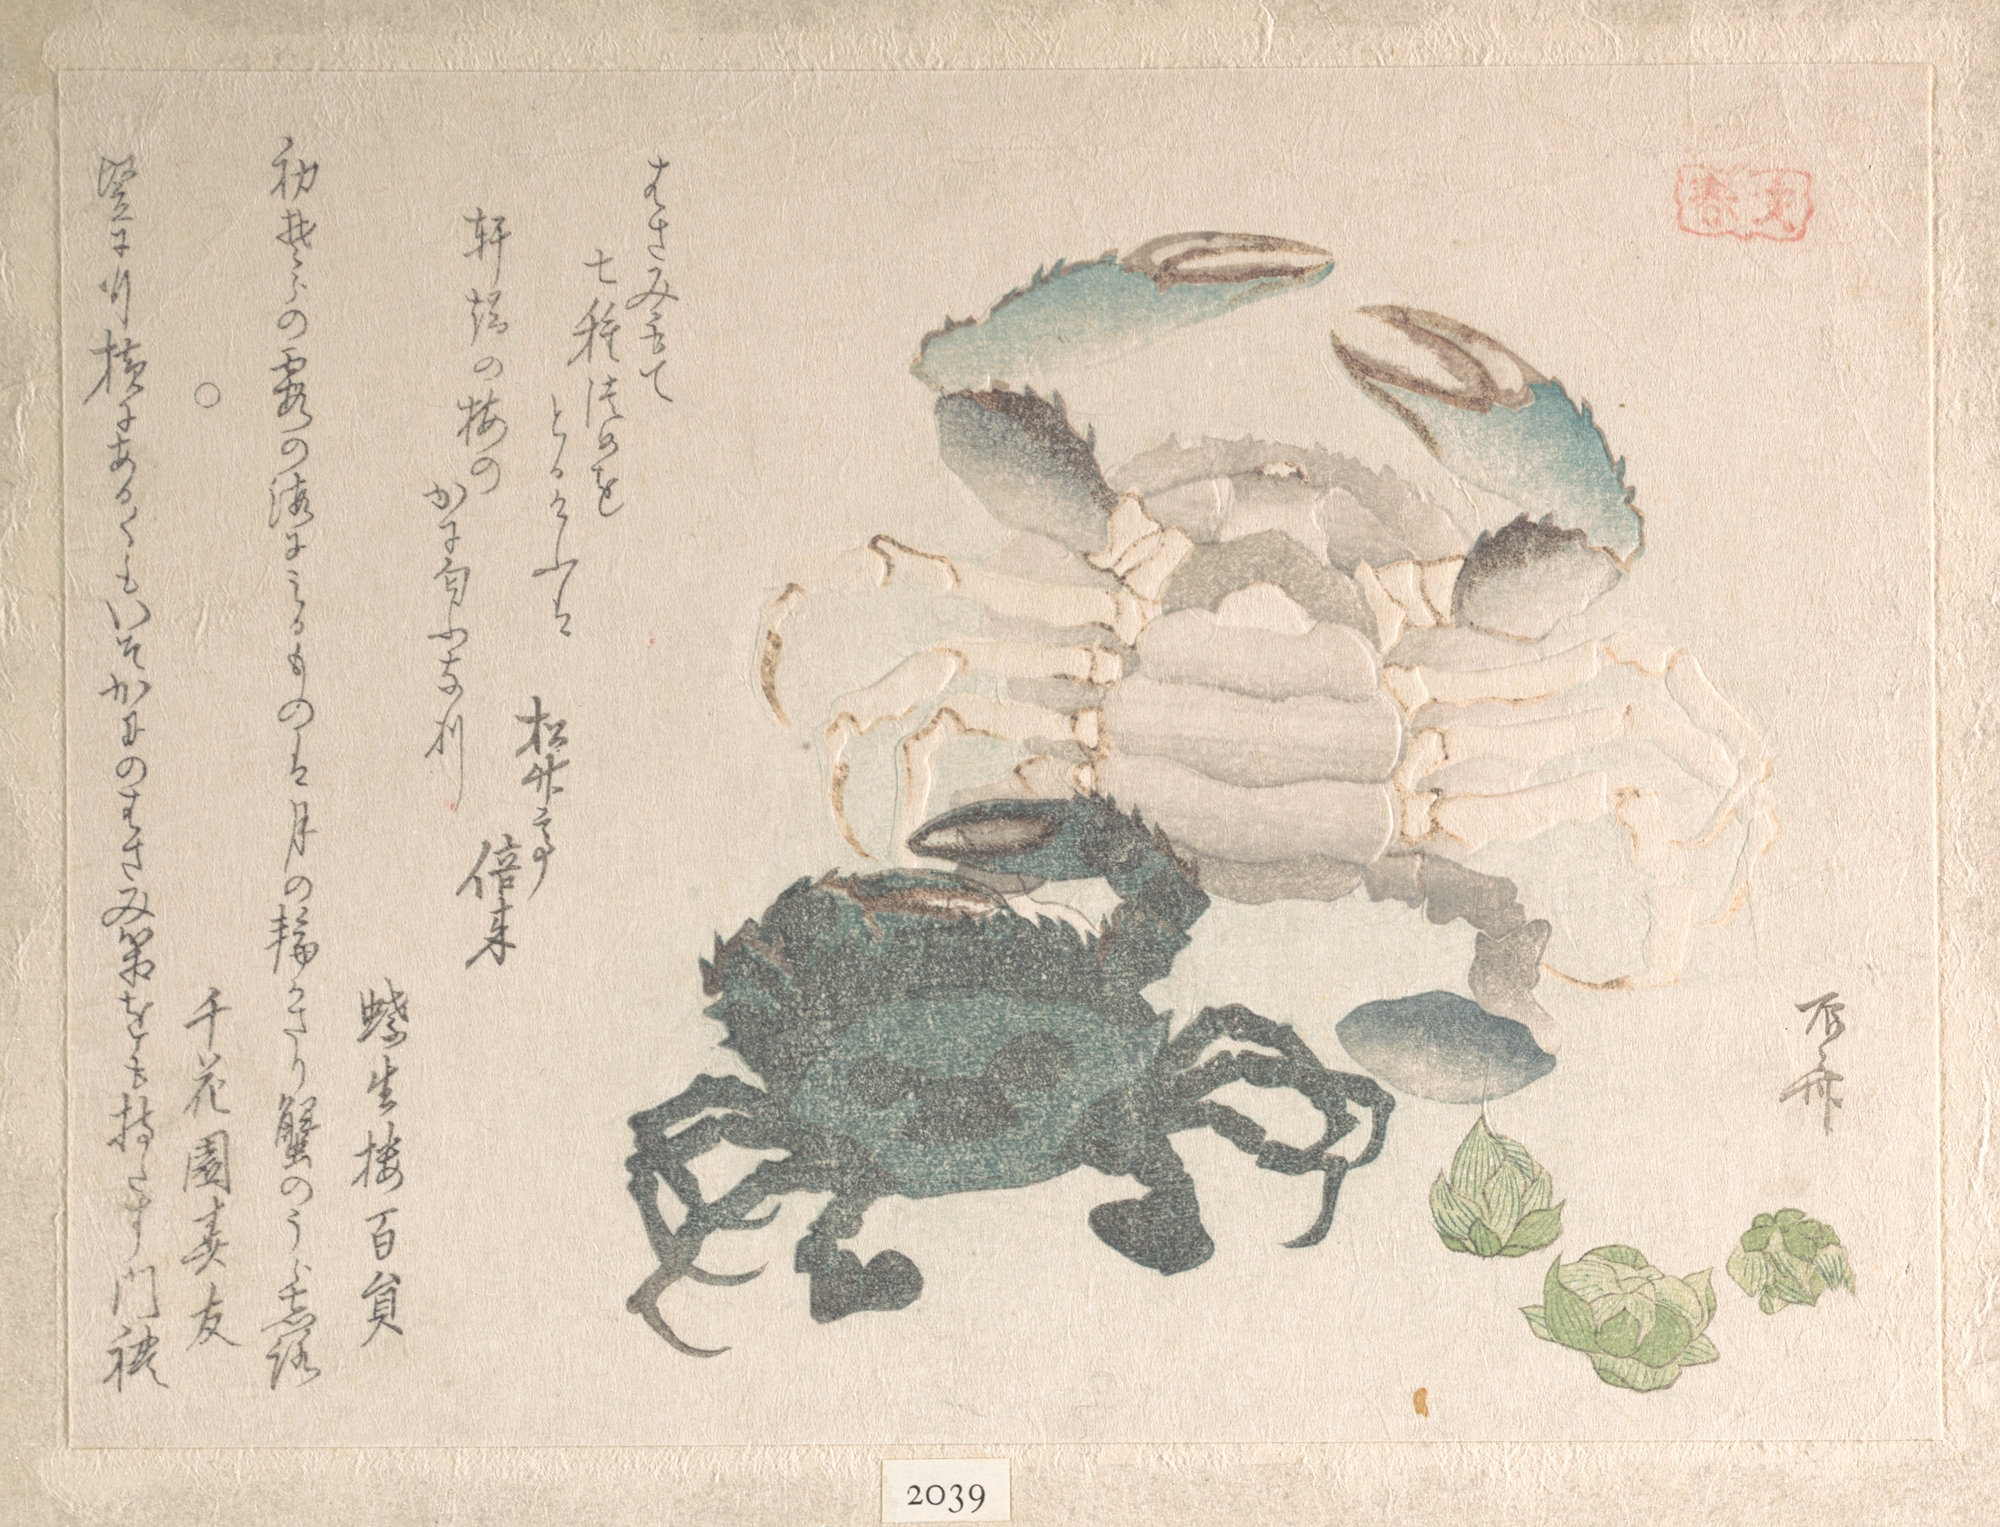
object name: print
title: Spring Rain Collection (Harusame shū), vol. 1: Crabs and Lotus Blossoms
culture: japanese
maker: ryūryūkyo shinsai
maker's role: artist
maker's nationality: japanese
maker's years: 1799-1823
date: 1805-1810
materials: ink, paper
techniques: surimono, woodblock print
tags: crabs,lotuses